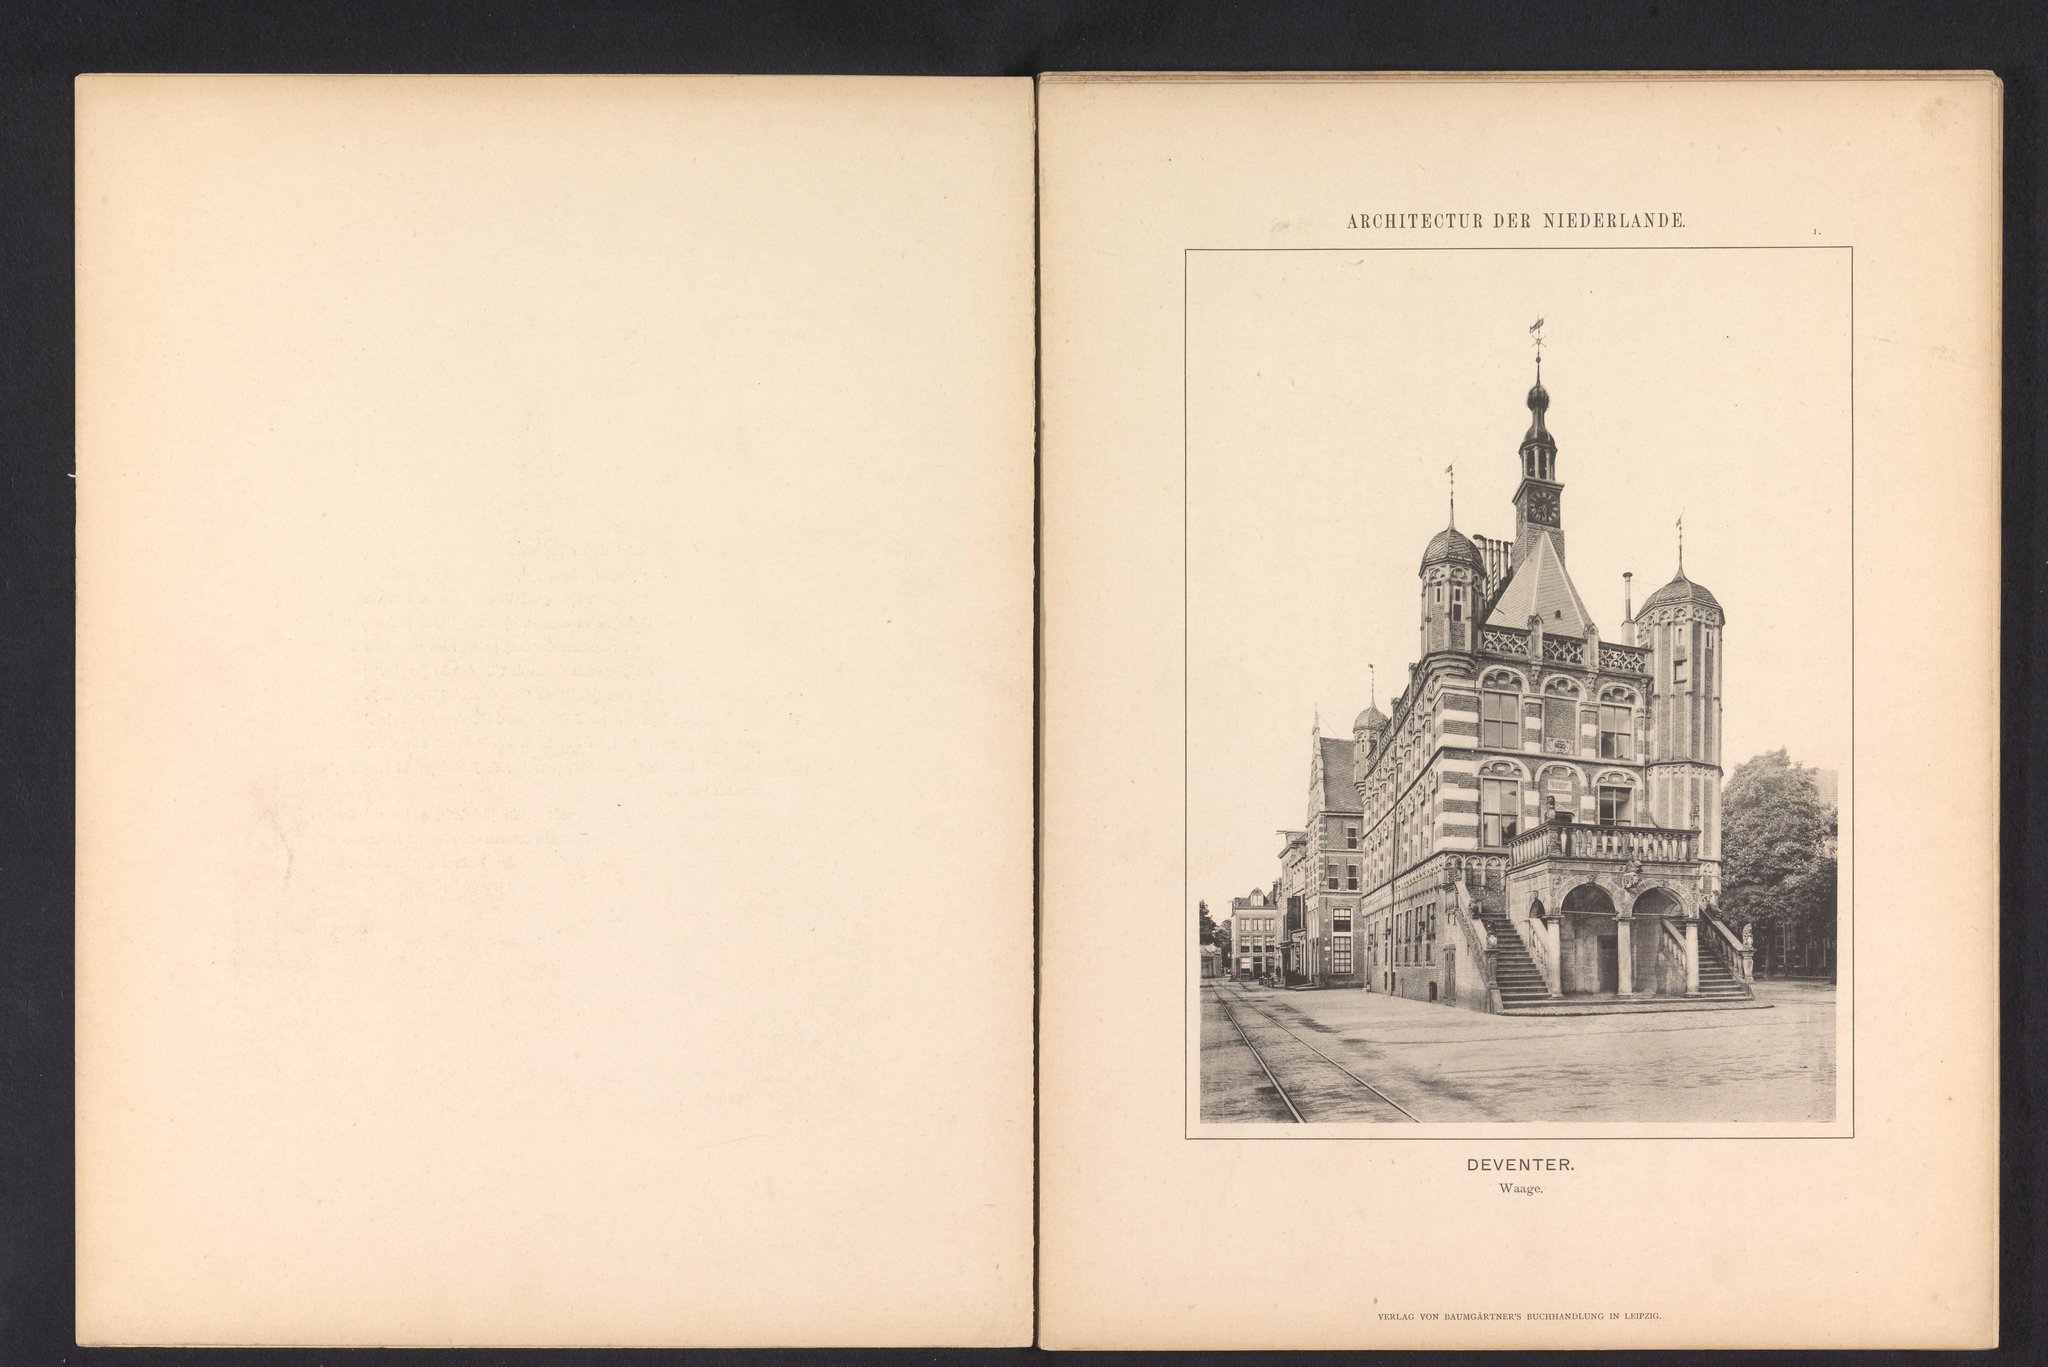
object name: photomechanical print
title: Deventer. Waage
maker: Anonymous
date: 1884-1894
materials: paper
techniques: photograph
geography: leipzig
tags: façade (of house or building), weigh-house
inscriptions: number: ‘1.’